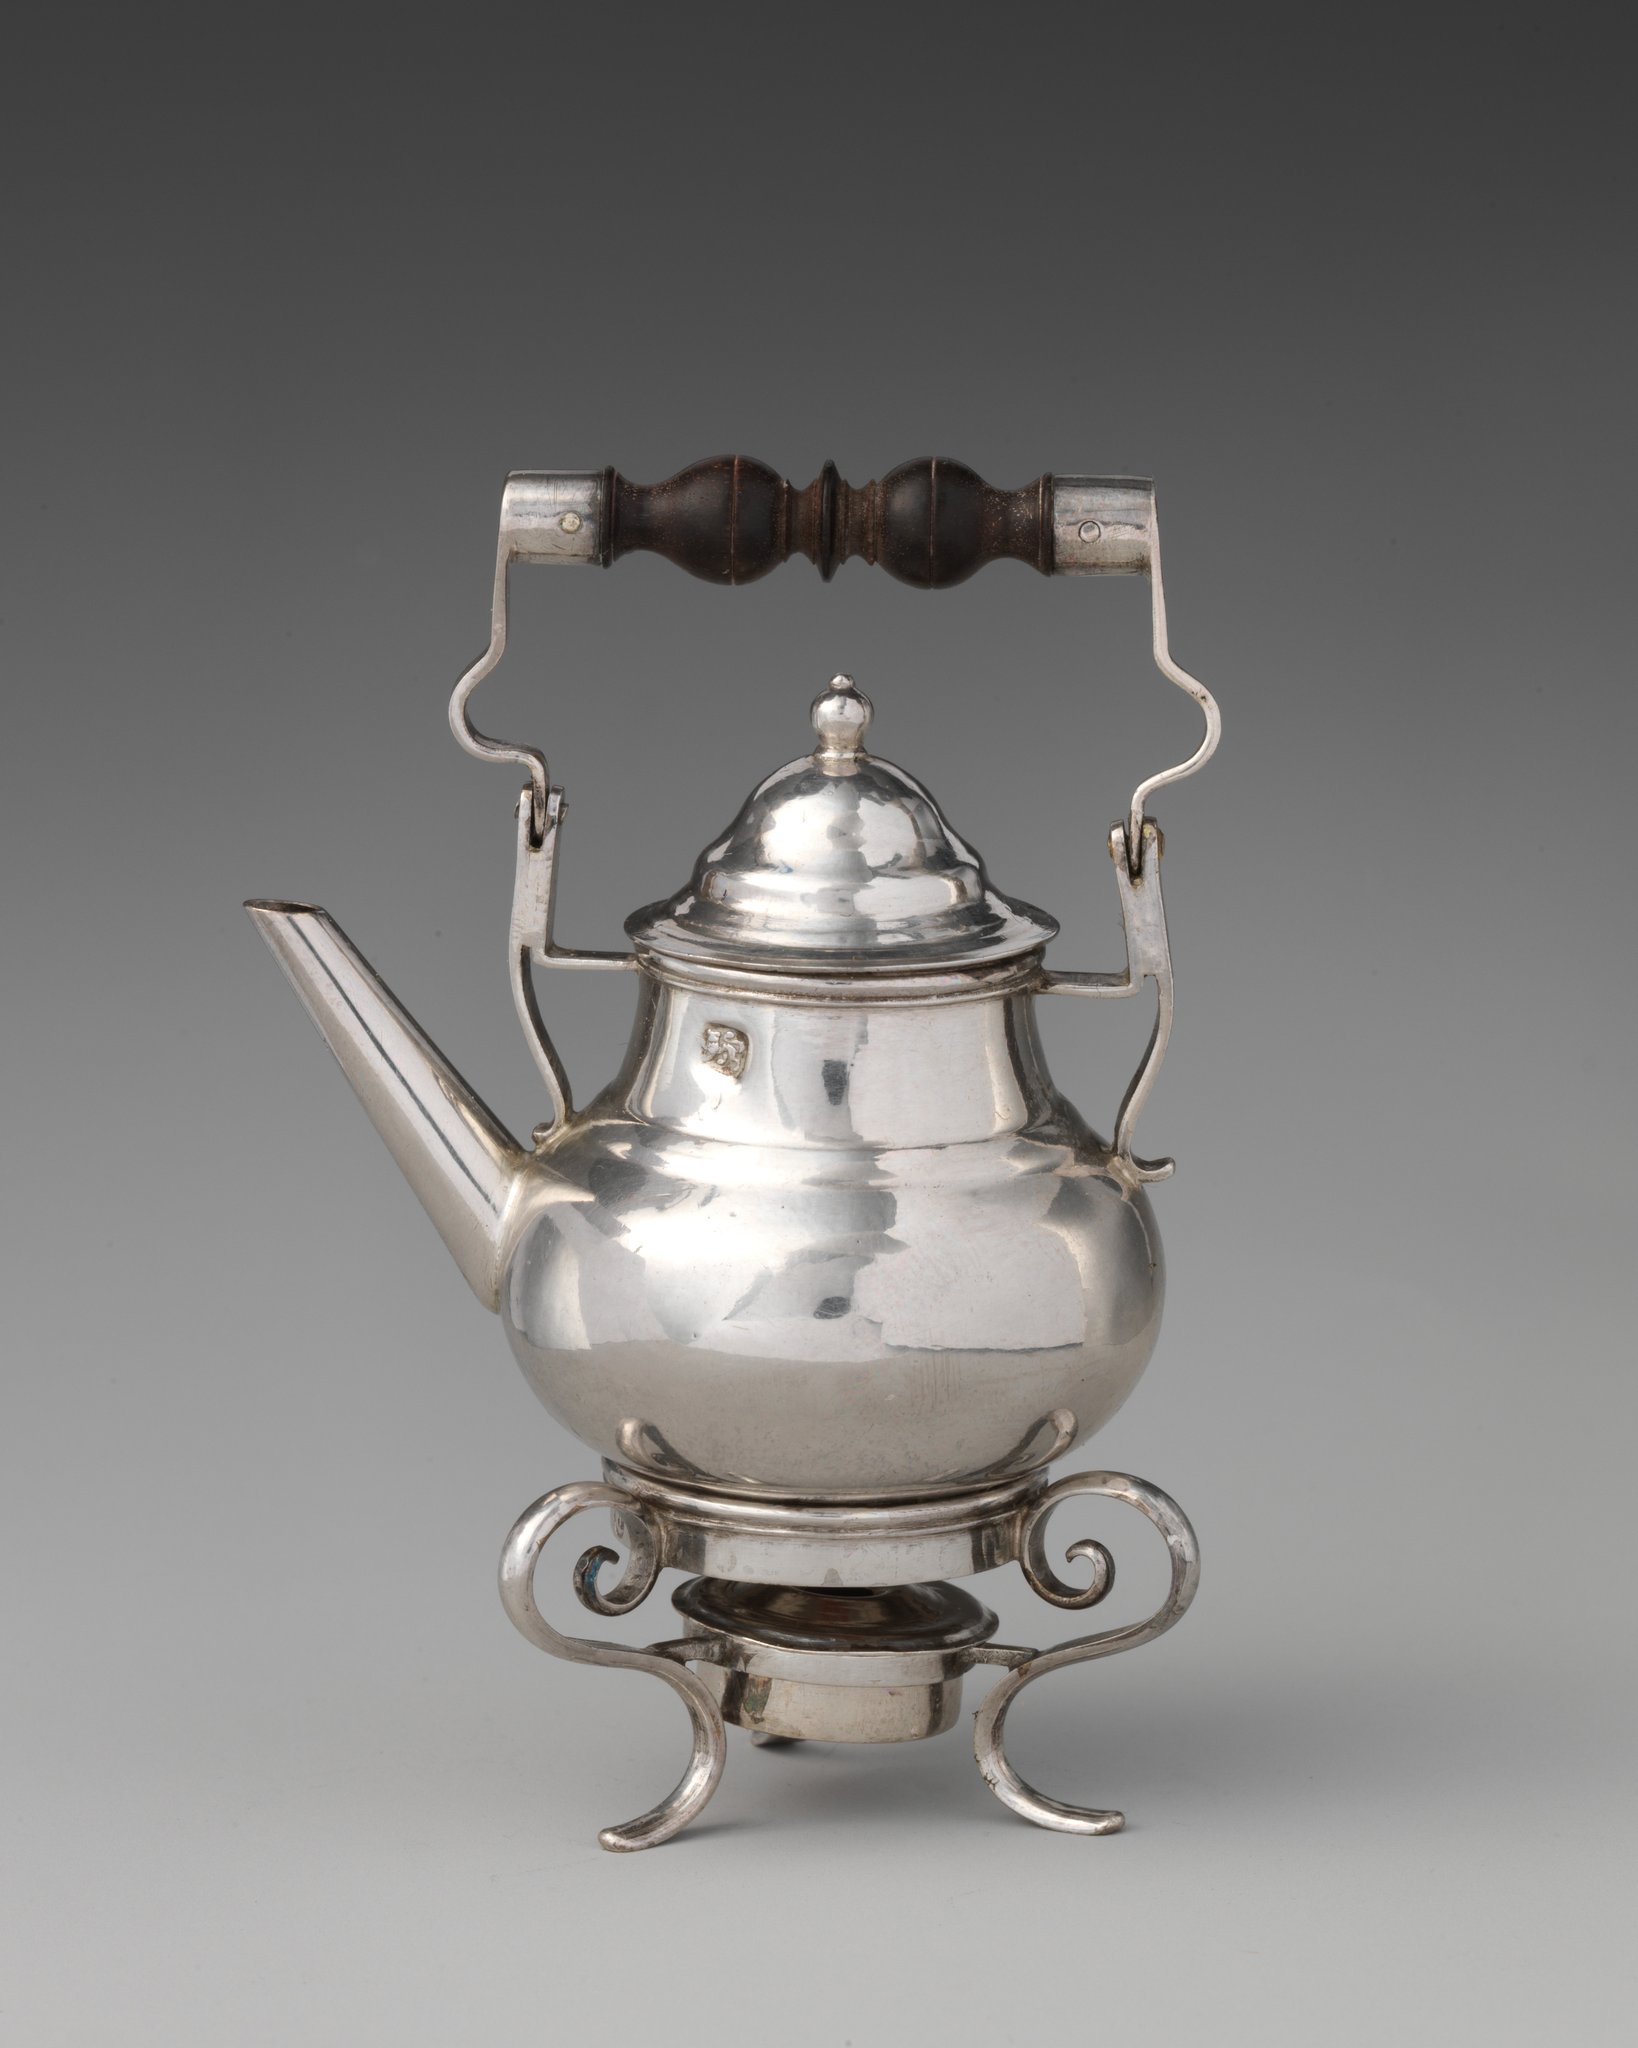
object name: kettle with cover, stand, and lamp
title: Miniature kettle with cover, stand, and lamp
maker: david clayton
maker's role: artist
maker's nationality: british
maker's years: 1659-1719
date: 1720-1730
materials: silver, wood